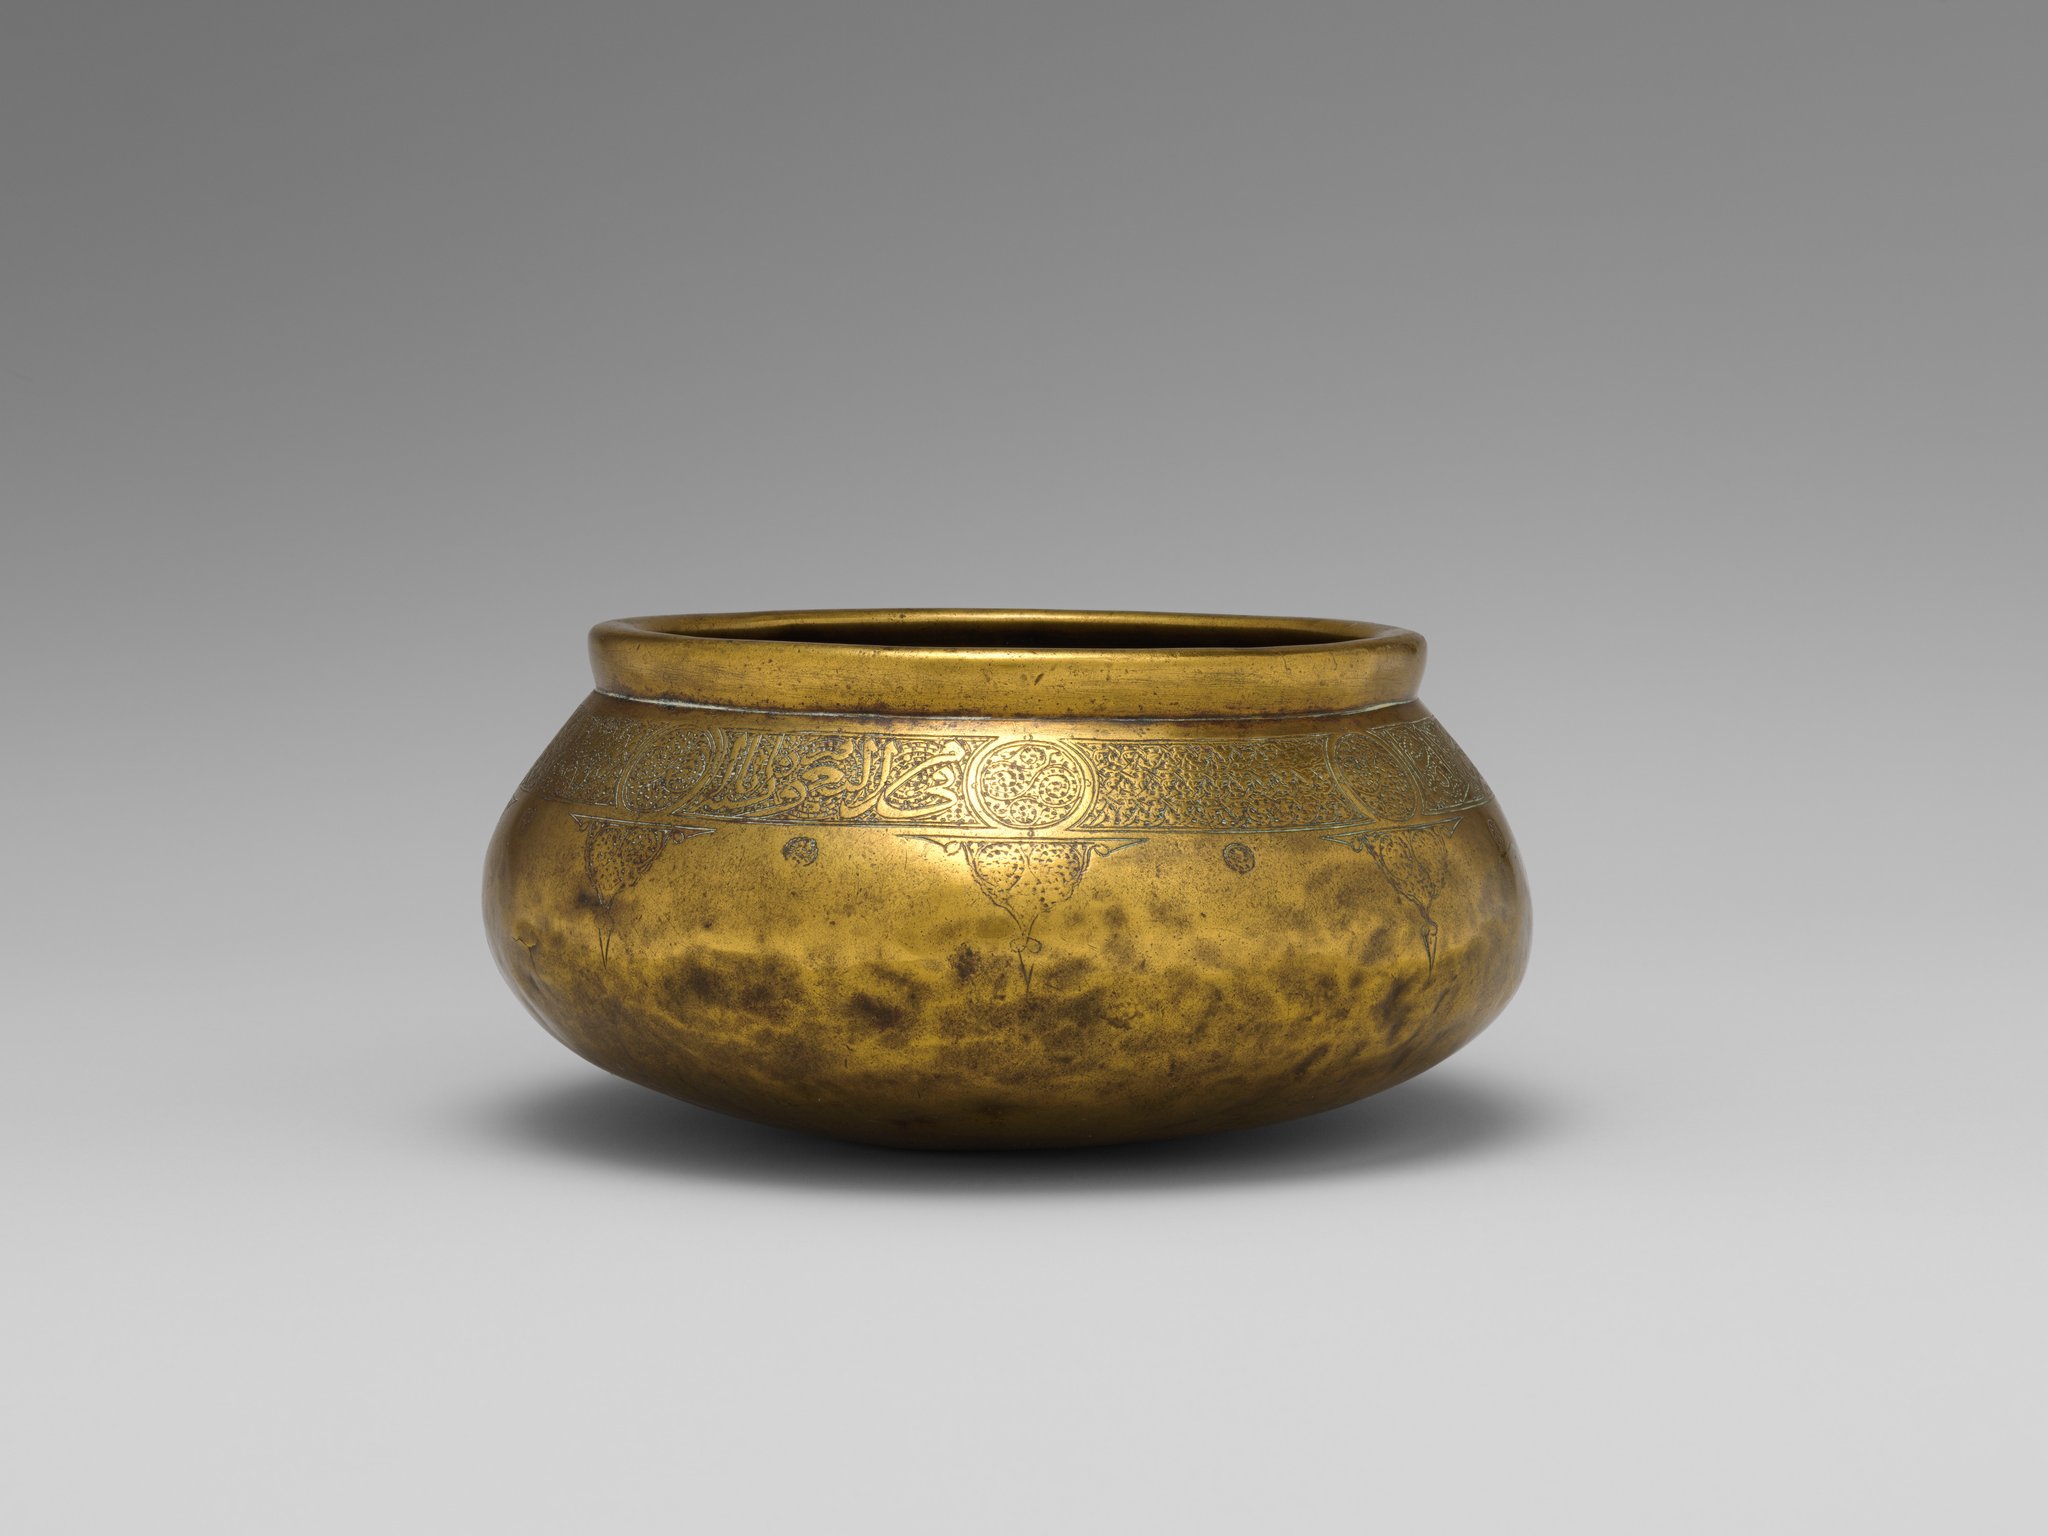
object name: bowl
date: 1301-1400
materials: brass, silver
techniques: inlay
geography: iran